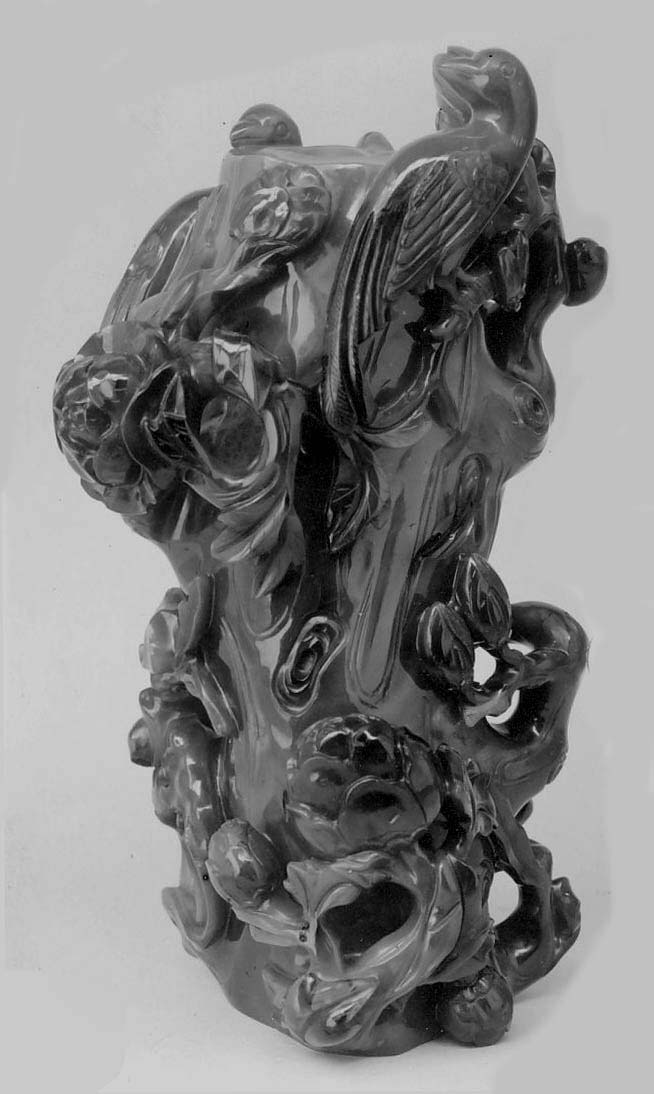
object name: vase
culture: chinese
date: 1736-1795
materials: stone, gemstone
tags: birds